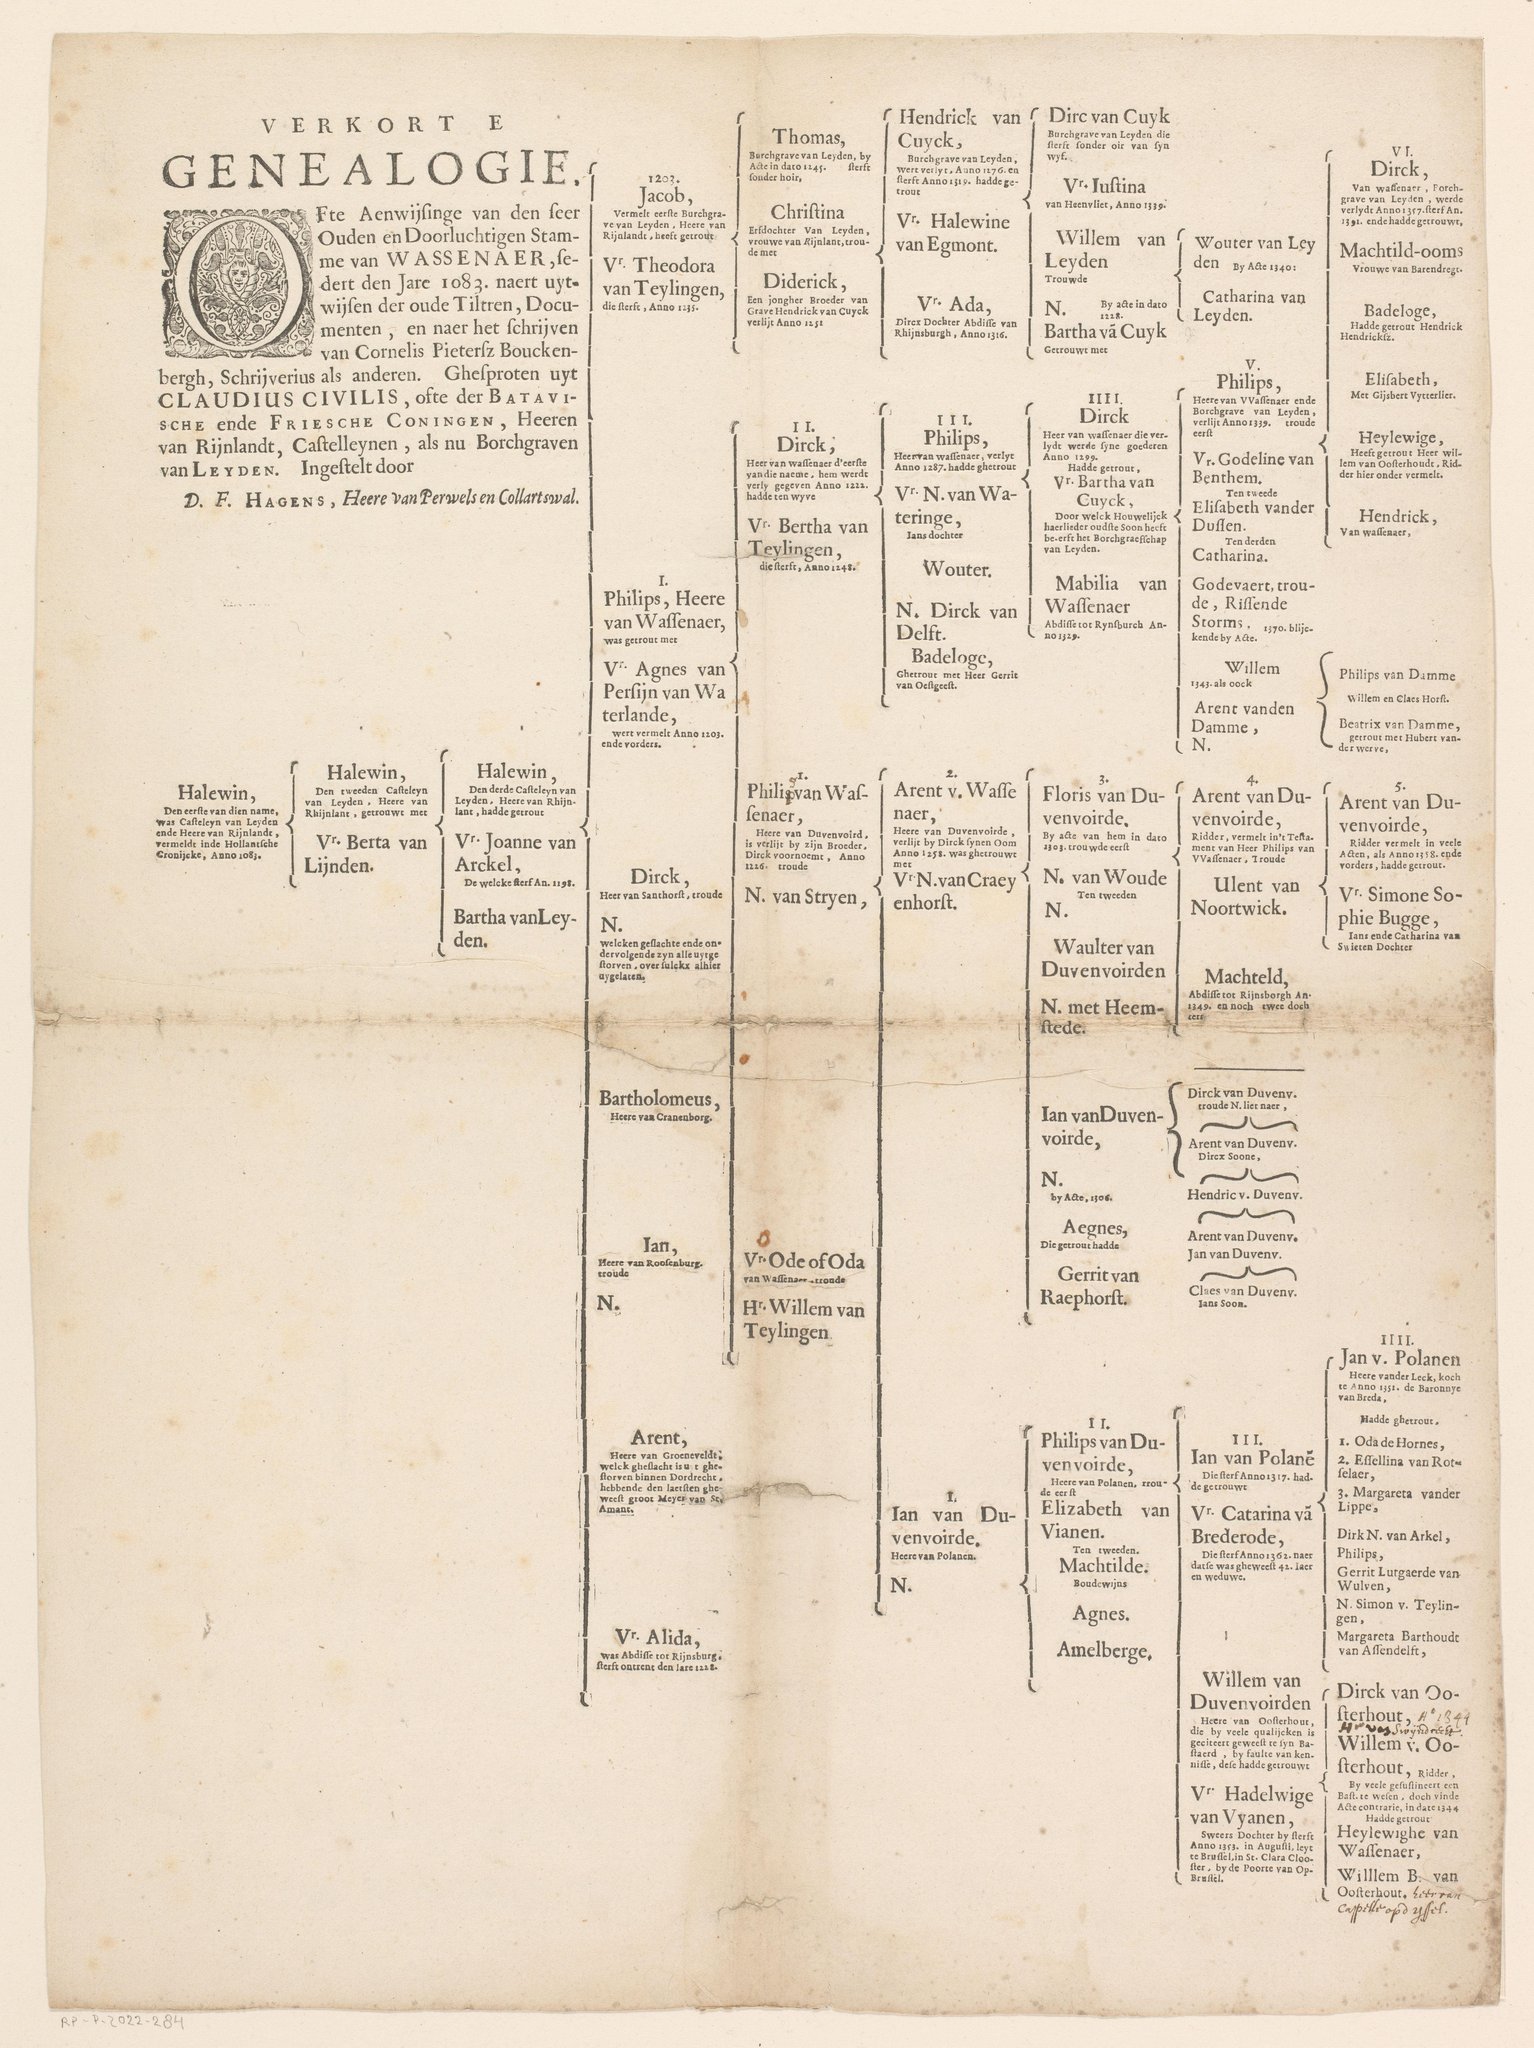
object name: text sheet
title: Verkorte genealogie, ofte aenwijsinge van den seer ouden en doorluchtigen stamme Van Wassenaer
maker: Anonymous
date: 1650-1670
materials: paper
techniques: letterpress printing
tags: family lineage, pedigree, genealogical tree or table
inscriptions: collector's mark: Lugt 2228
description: Zie RP-P-2022-285 voor het vervolg van de tabel.